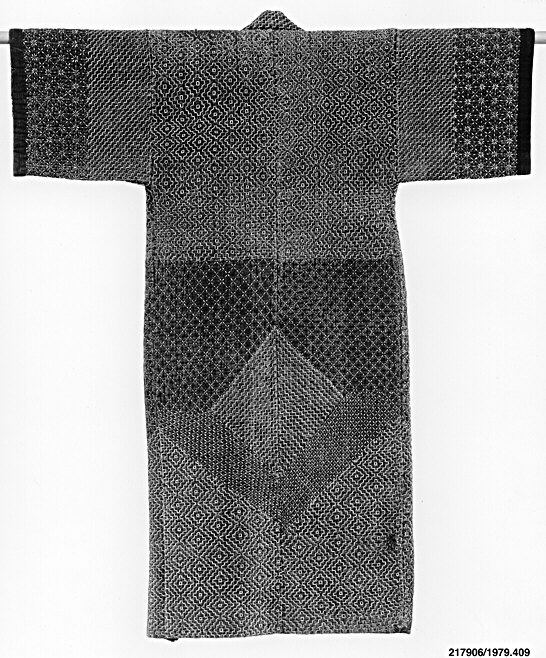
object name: sashiko kimono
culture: japanese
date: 1834-1866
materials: cotton, thread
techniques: dyeing, embroidery, weave